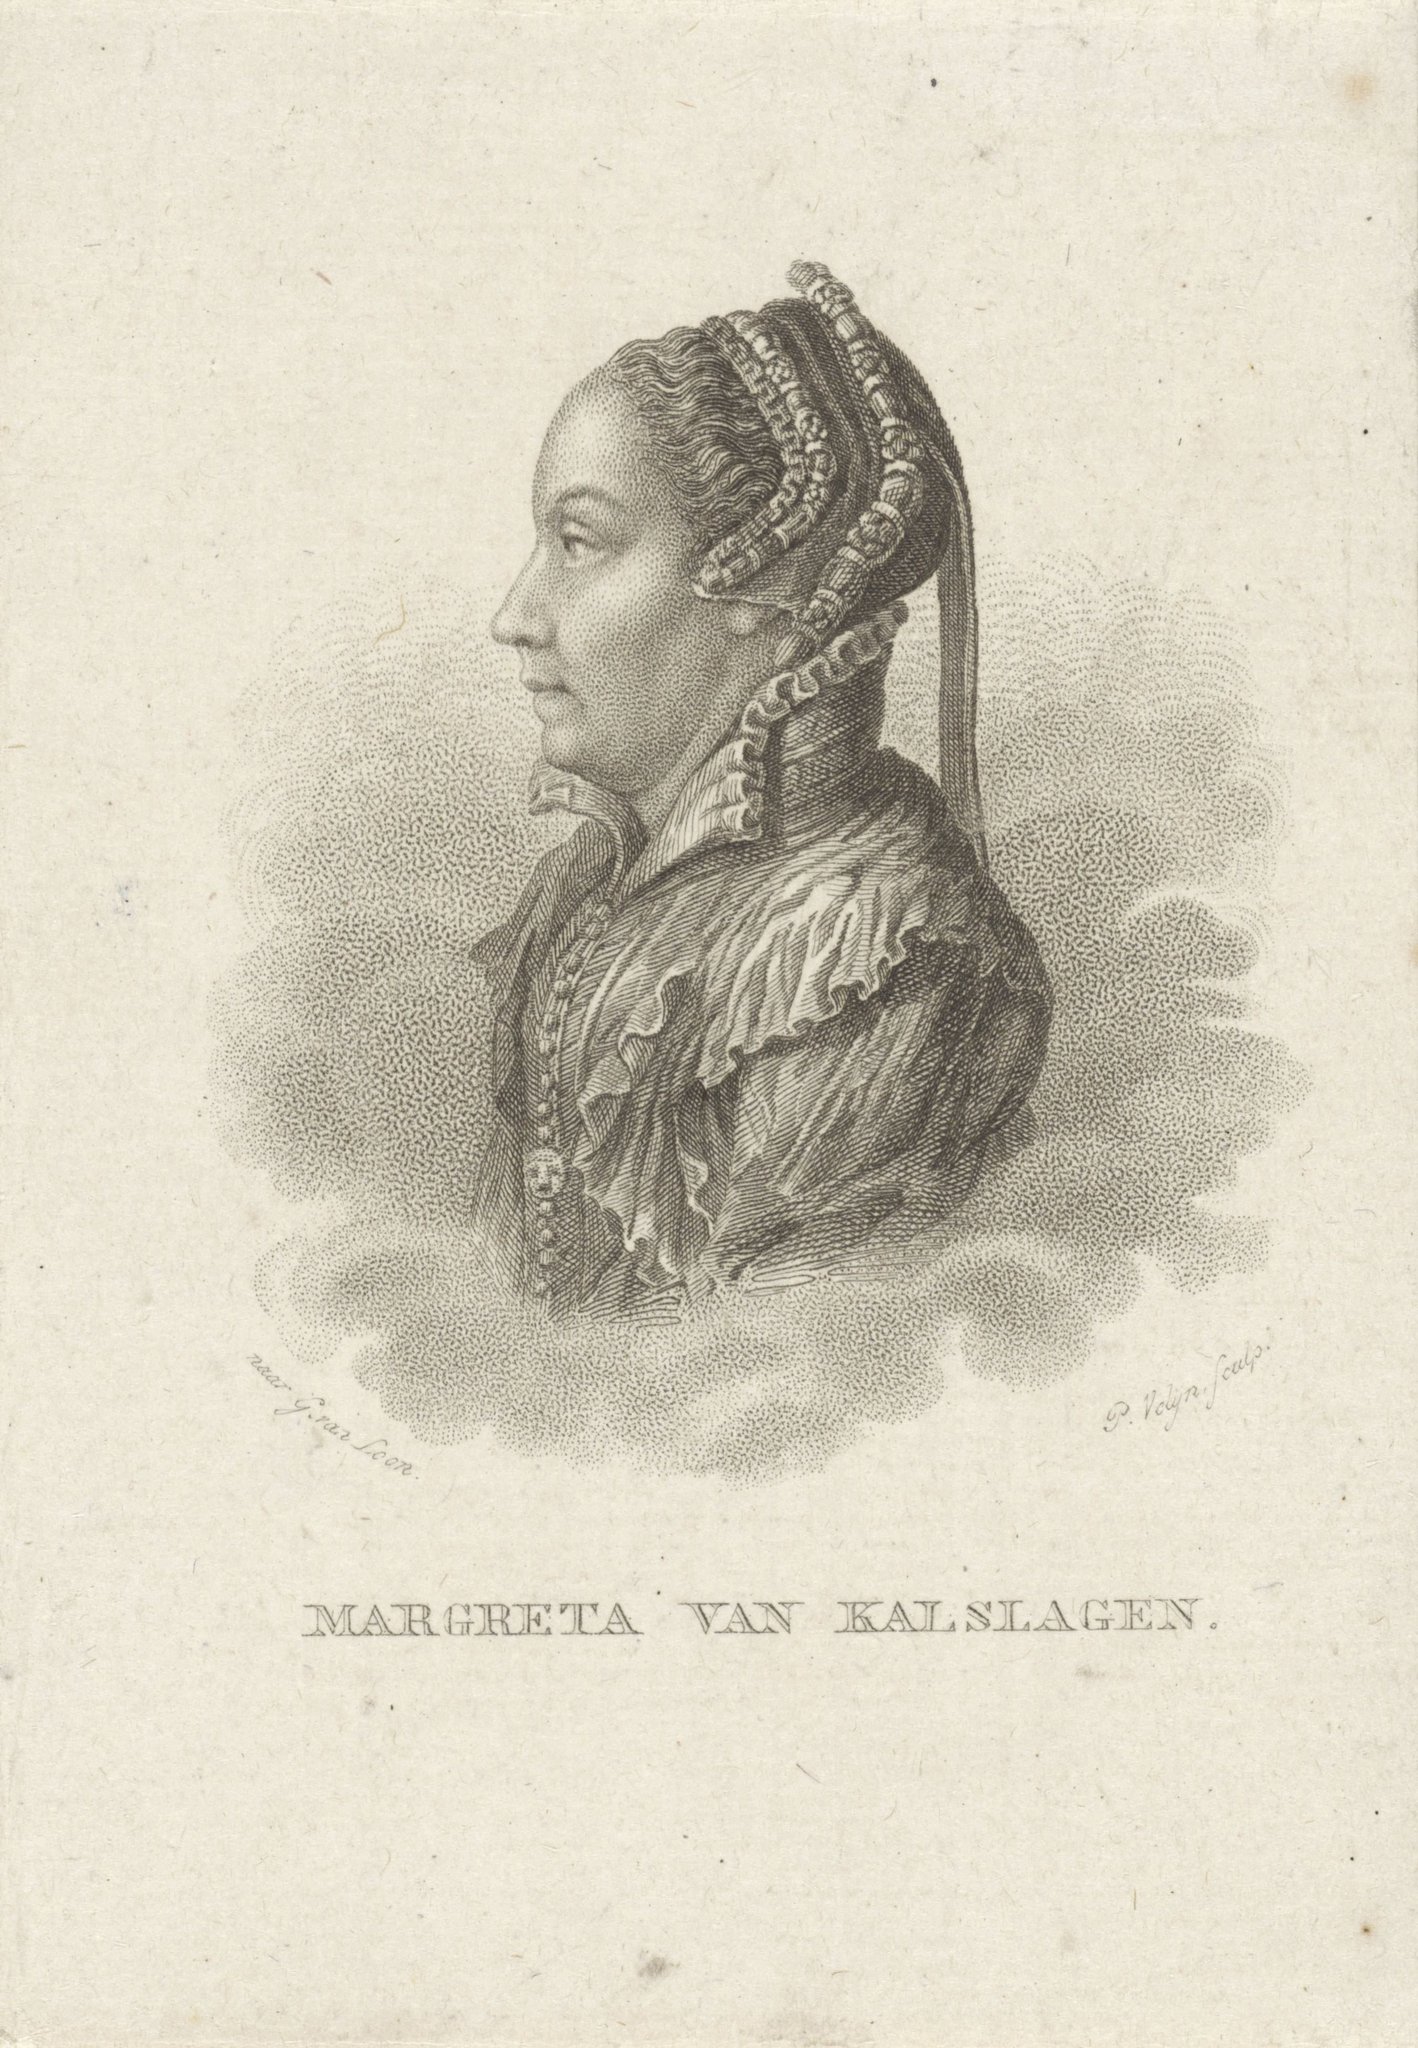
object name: print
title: Portret van Margaretha Coppier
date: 1797-1836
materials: paper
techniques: engraving, etching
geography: netherlands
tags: breda, margaretha coppier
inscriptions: collector's mark: Lugt 2228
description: Portret van Margaretha Coppier, genoemd Margaretha van Kalslagen, zestiende eeuwse heldin van Antwerpen.